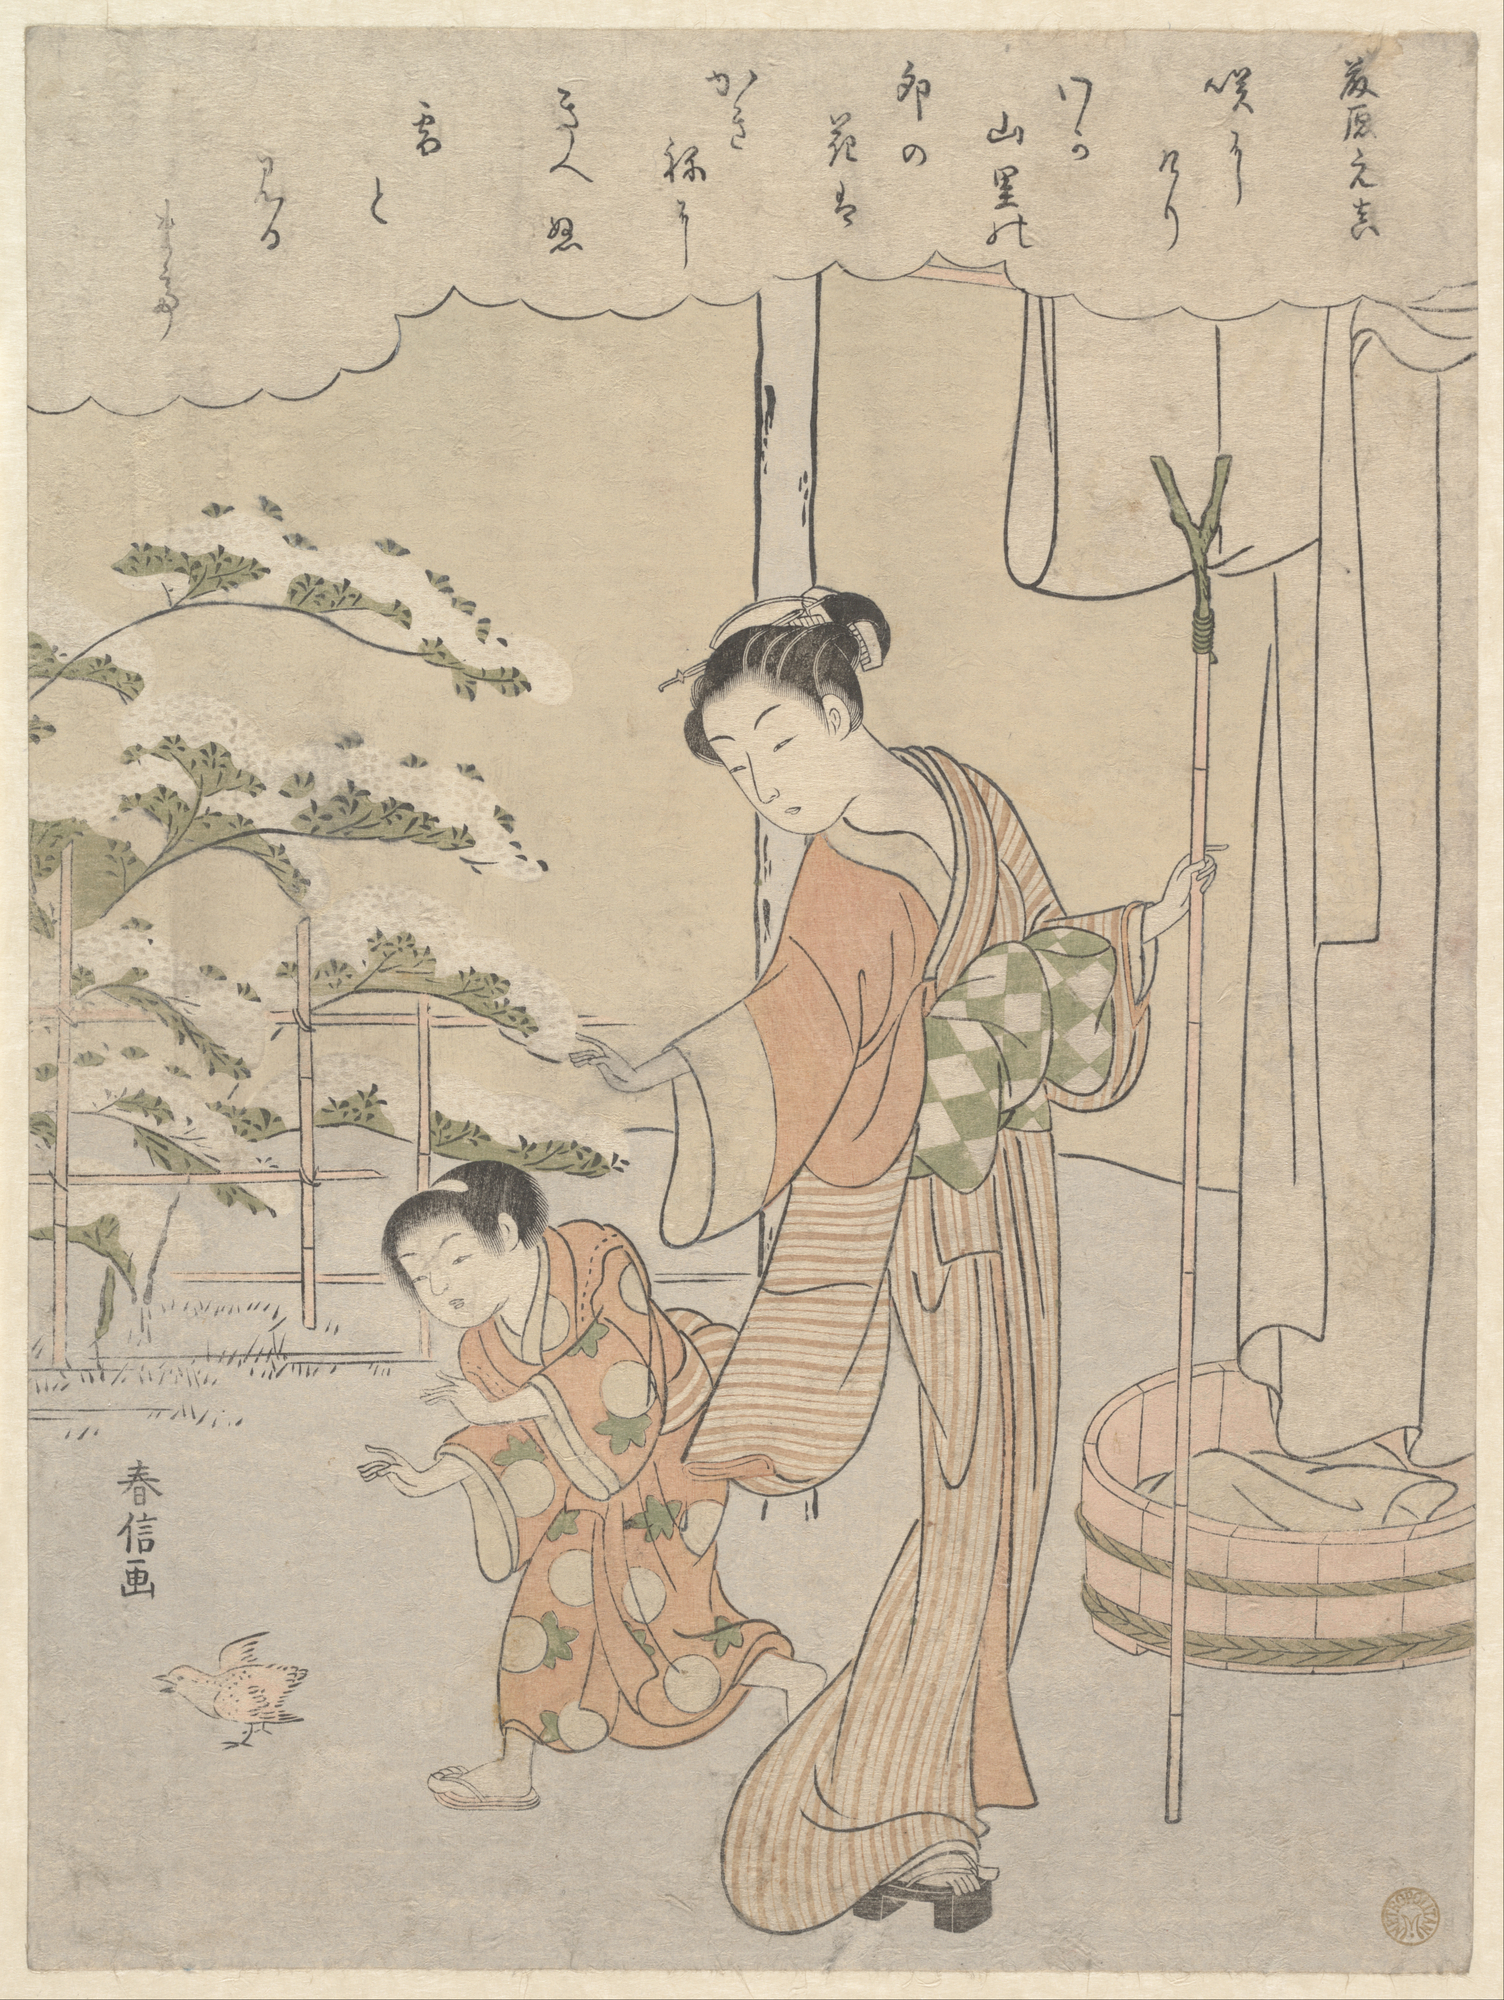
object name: print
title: Poem by Fujiwara no Motozane (ca. 860) from the Series Thirty-Six Poets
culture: japanese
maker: suzuki harunobu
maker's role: artist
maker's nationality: japanese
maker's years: 1725-1770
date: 1768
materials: ink, paper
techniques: woodblock print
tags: birds,boys,women